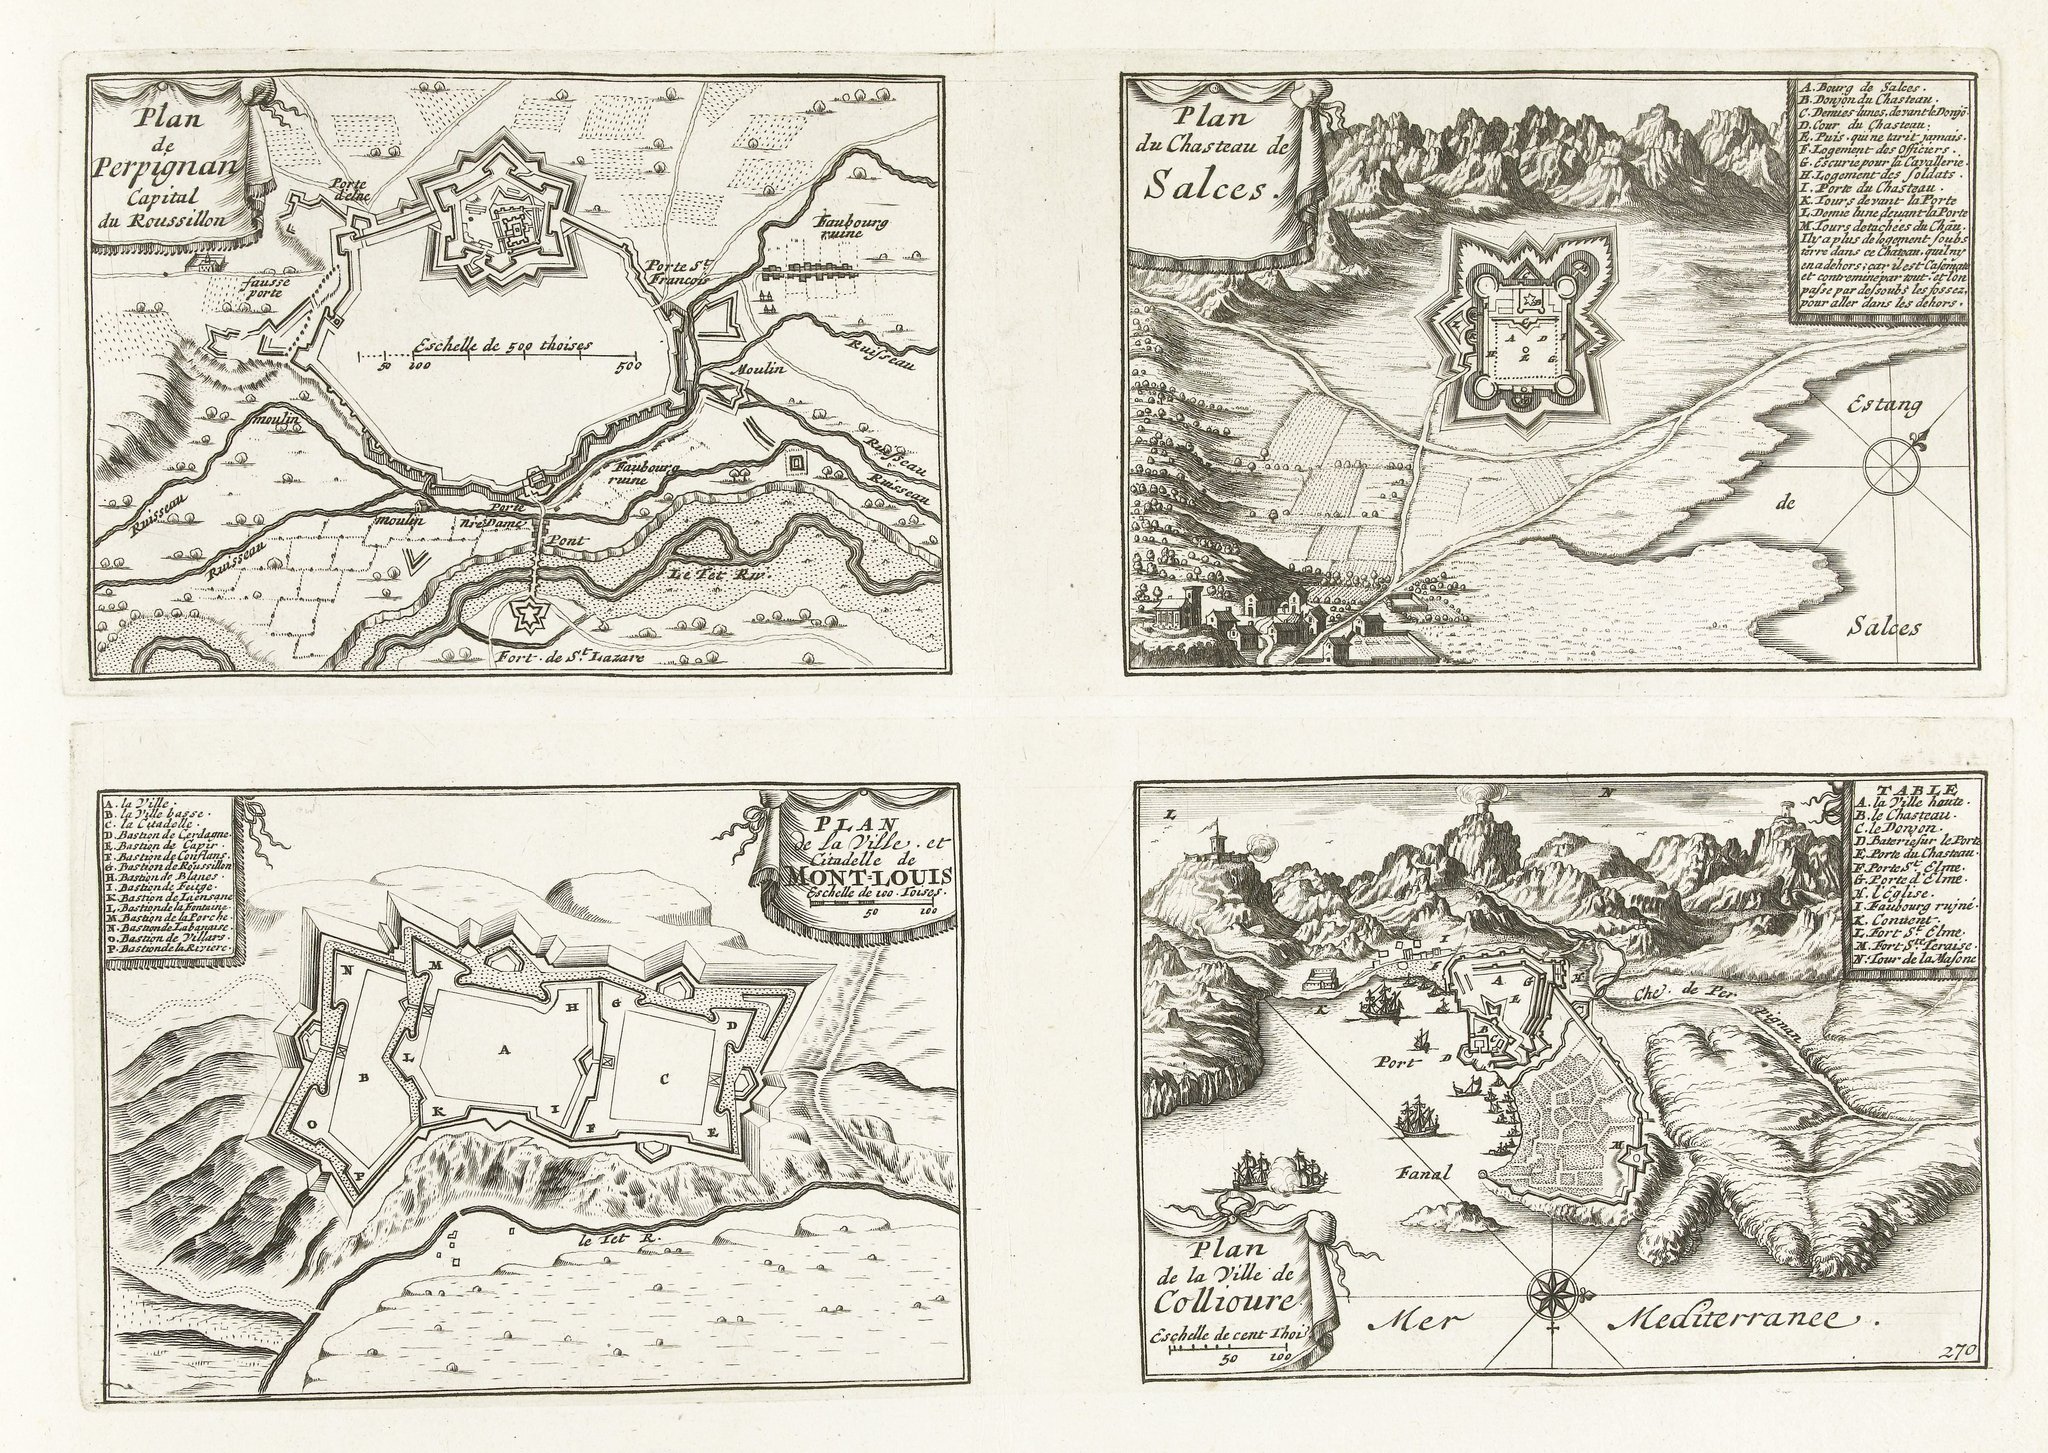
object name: print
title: Les Forces de l'Europe, Asie, Afrique et Amerique, ou description des principales villes avec leurs fortifications. Dessignées par les meilleurs ingenieurs, particulierement celles qui sont sous la domination de la France (...) et ornées de plusieurs superbes edifices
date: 1702-1703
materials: paper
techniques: etching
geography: northern netherlands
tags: fortress, maps of cities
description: Blad met twee platen met elk twee plattegronden van de versterkingen om de Franse steden Perpignan, Salces, Mont-Louis en Collioure in Languedoc-Roussillon. Plaat nr. 270 in het prentwerk bestaande in totaal uit 276 genummerde platen van vermaarde sterke steden en vestingen in het kader van de Spaanse Successieoorlog. Voor het merendeel zijn deze platen gekopieerd naar de anonieme Franse platen: in Les forces de l'Europe en in: Le theatre de la guerre, dans les Pays-Bas, beide oorspronkelijk uitgegeven door Nicolas de Fer te Parijs (1693-1697) in het kader van de Negenjarige Oorlog. Titels en opschriften in de plaat in het Frans.